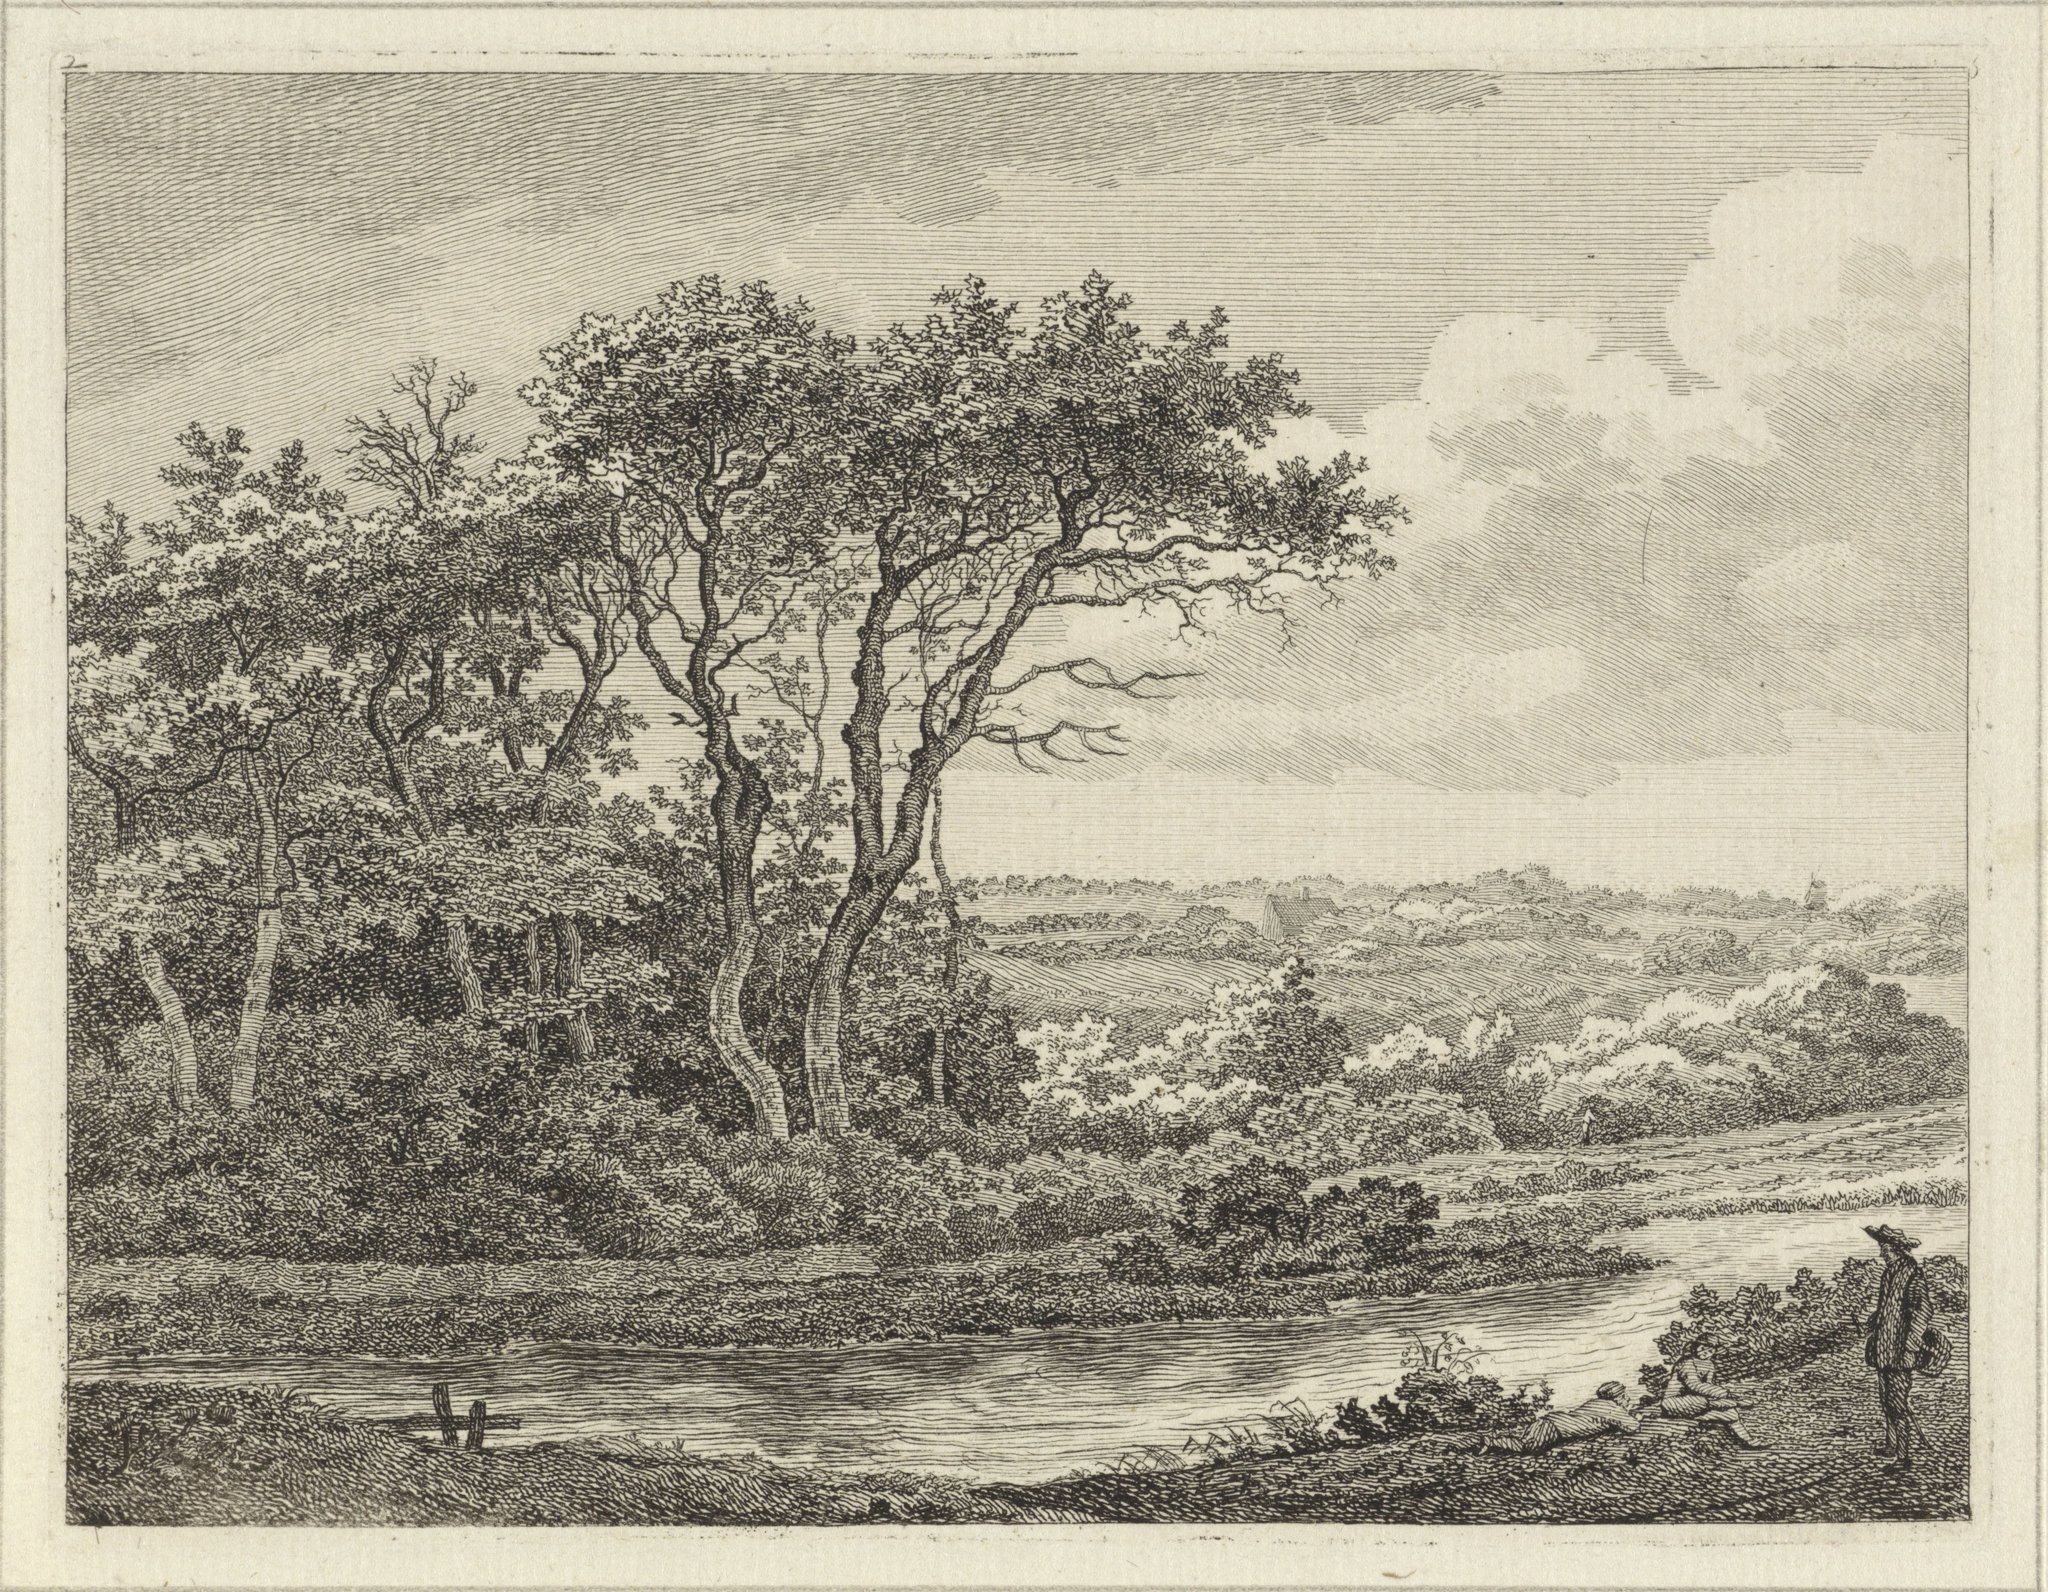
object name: print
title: Landschap met rivier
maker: adrianus serné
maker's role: print maker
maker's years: 1773-1853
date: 1783-1853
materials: paper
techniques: engraving, etching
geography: netherlands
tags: river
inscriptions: collector's mark: Lugt 2228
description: Landschap met rivier. Rechts op de voorgrond drie figuren.